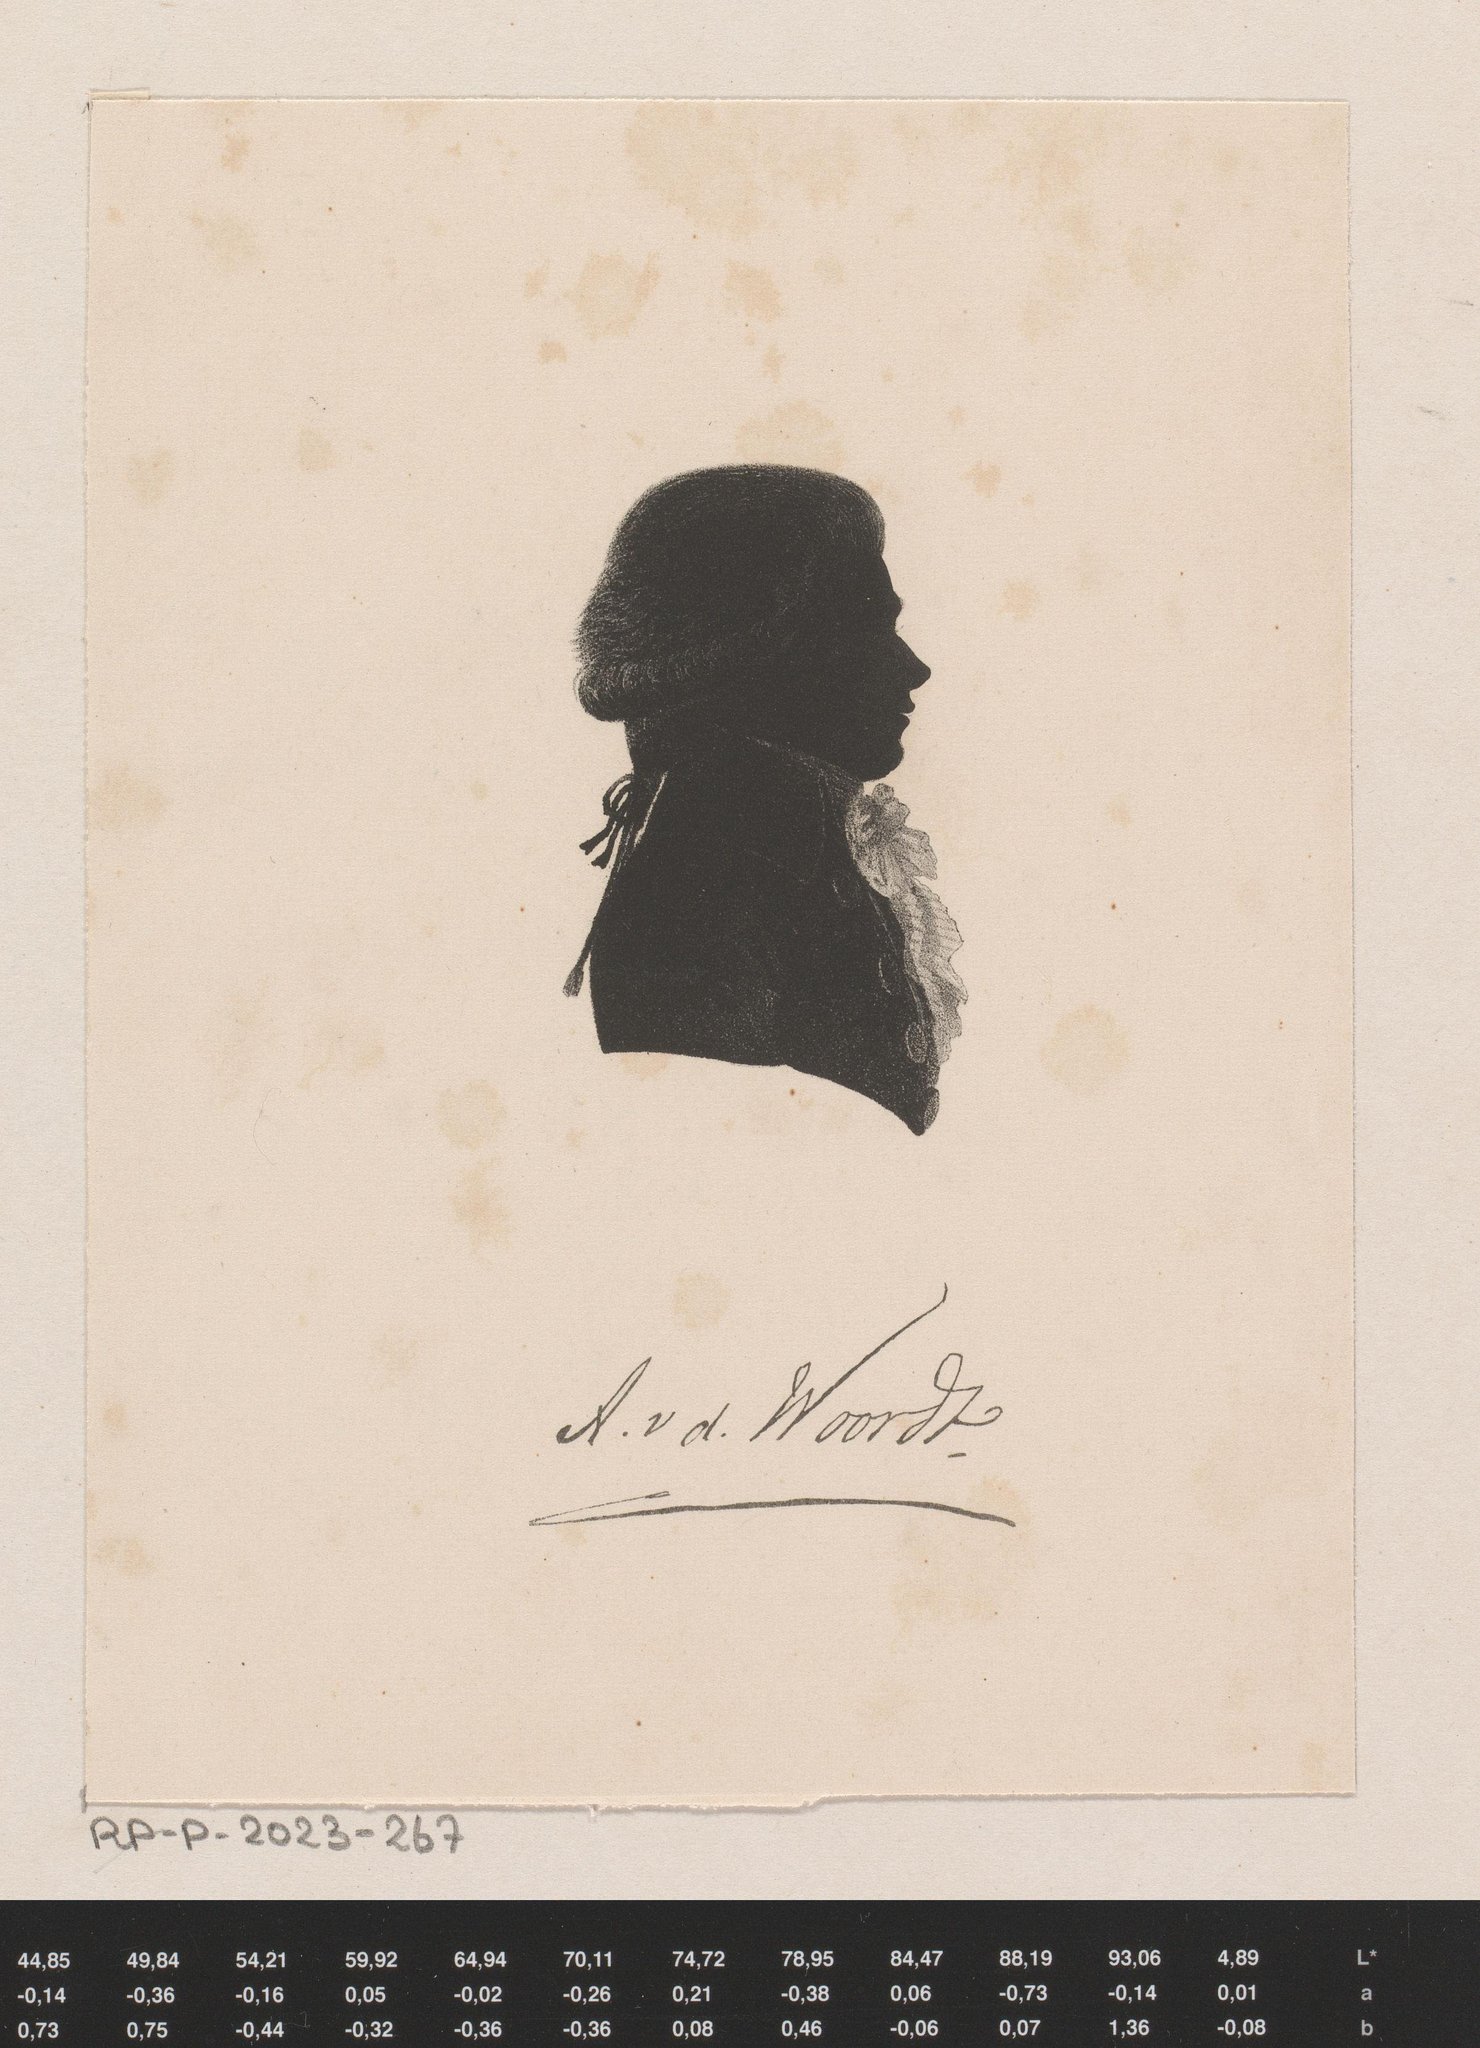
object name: print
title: Portret van Anthony van der Woordt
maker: Anonymous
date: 1798-1850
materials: paper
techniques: lithograph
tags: flushing, amsterdam, historical persons, portrait of a writer